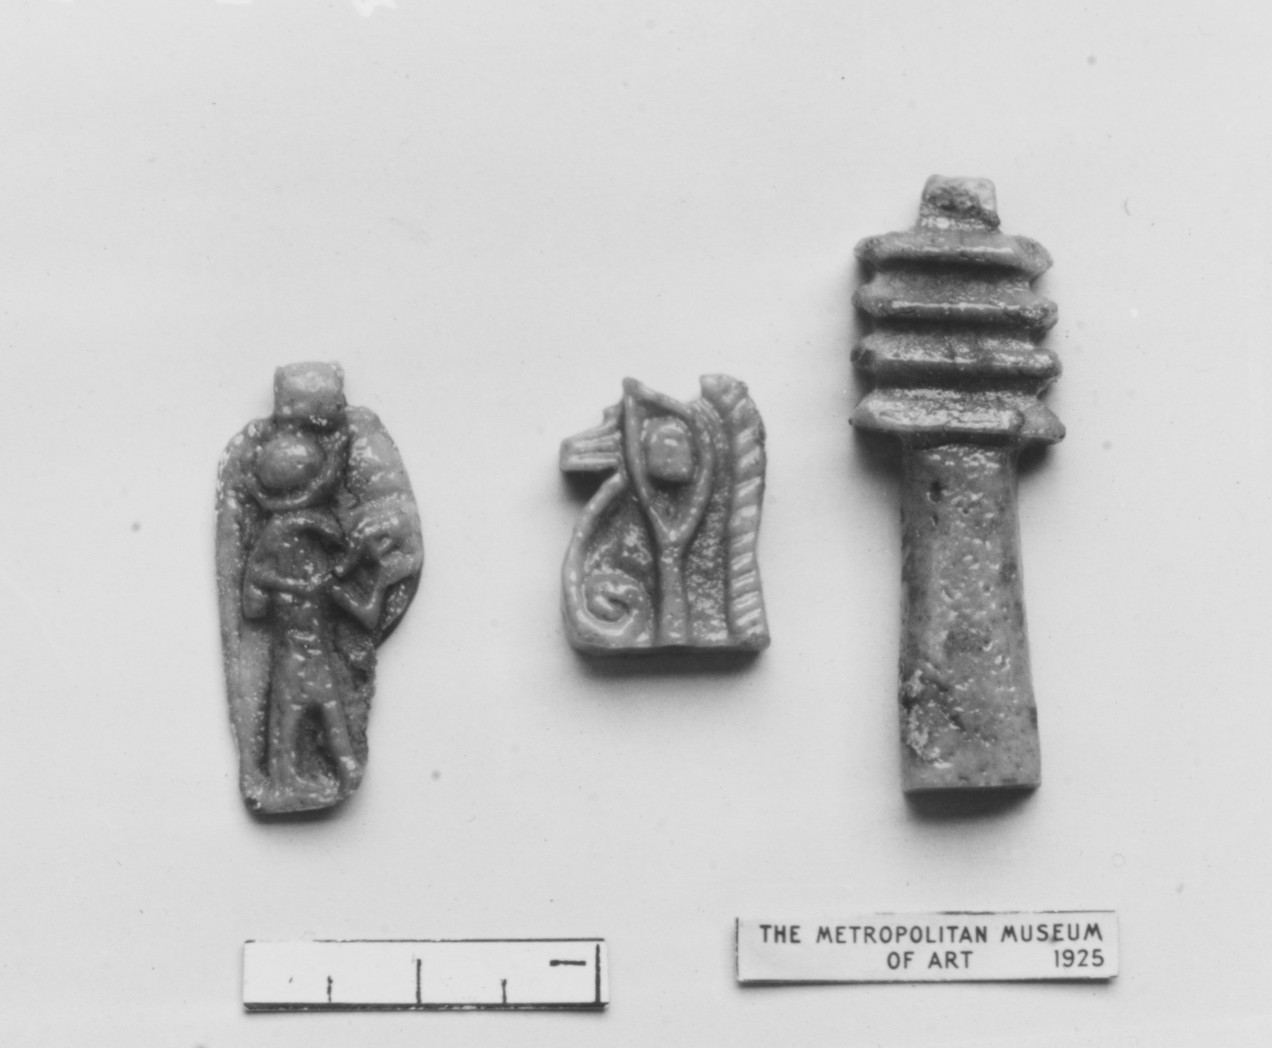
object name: amulet, djed pillar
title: Djed Pillar Amulet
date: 1000-945 BCE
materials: faience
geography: egypt